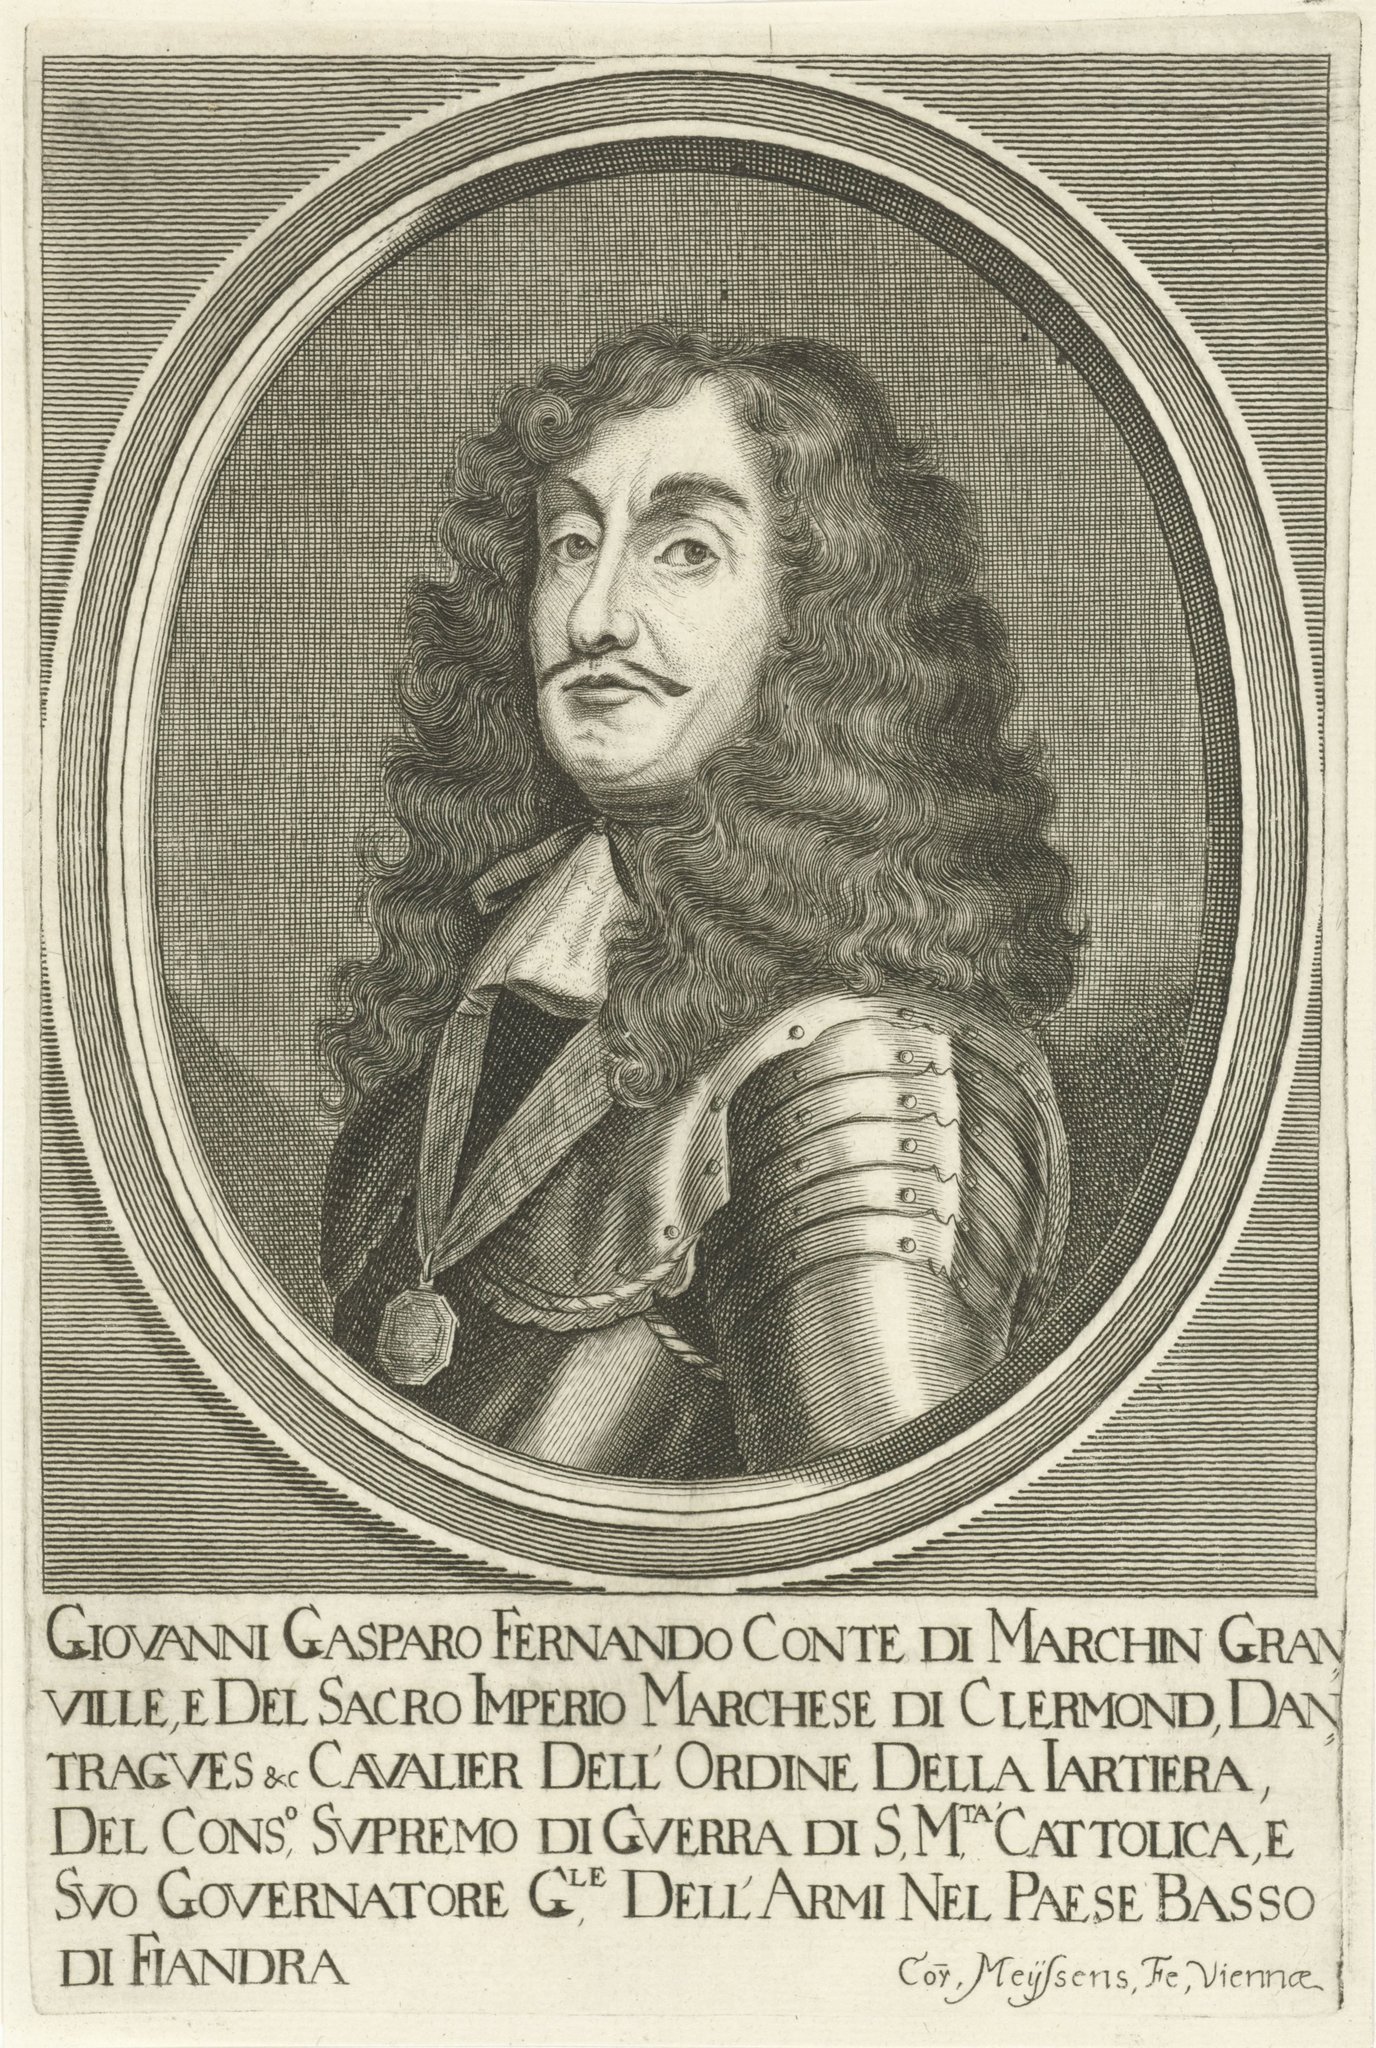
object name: print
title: Portret van Jean Gaspar Ferdinand de Marchin, graaf van Granville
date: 1670-1674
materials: paper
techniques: engraving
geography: vienna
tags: bevelhebber, jean gaspar ferdinand de marchin (graaf van granville)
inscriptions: collector's mark: Lugt 2228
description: Prent mogelijk gebruikt in: Gualdo Priorato, Galeazzo. Historia di Leopoldo Cesare, (...). 3 dln. Wenen, Giovanni Battista Hacque, 1670-1674.